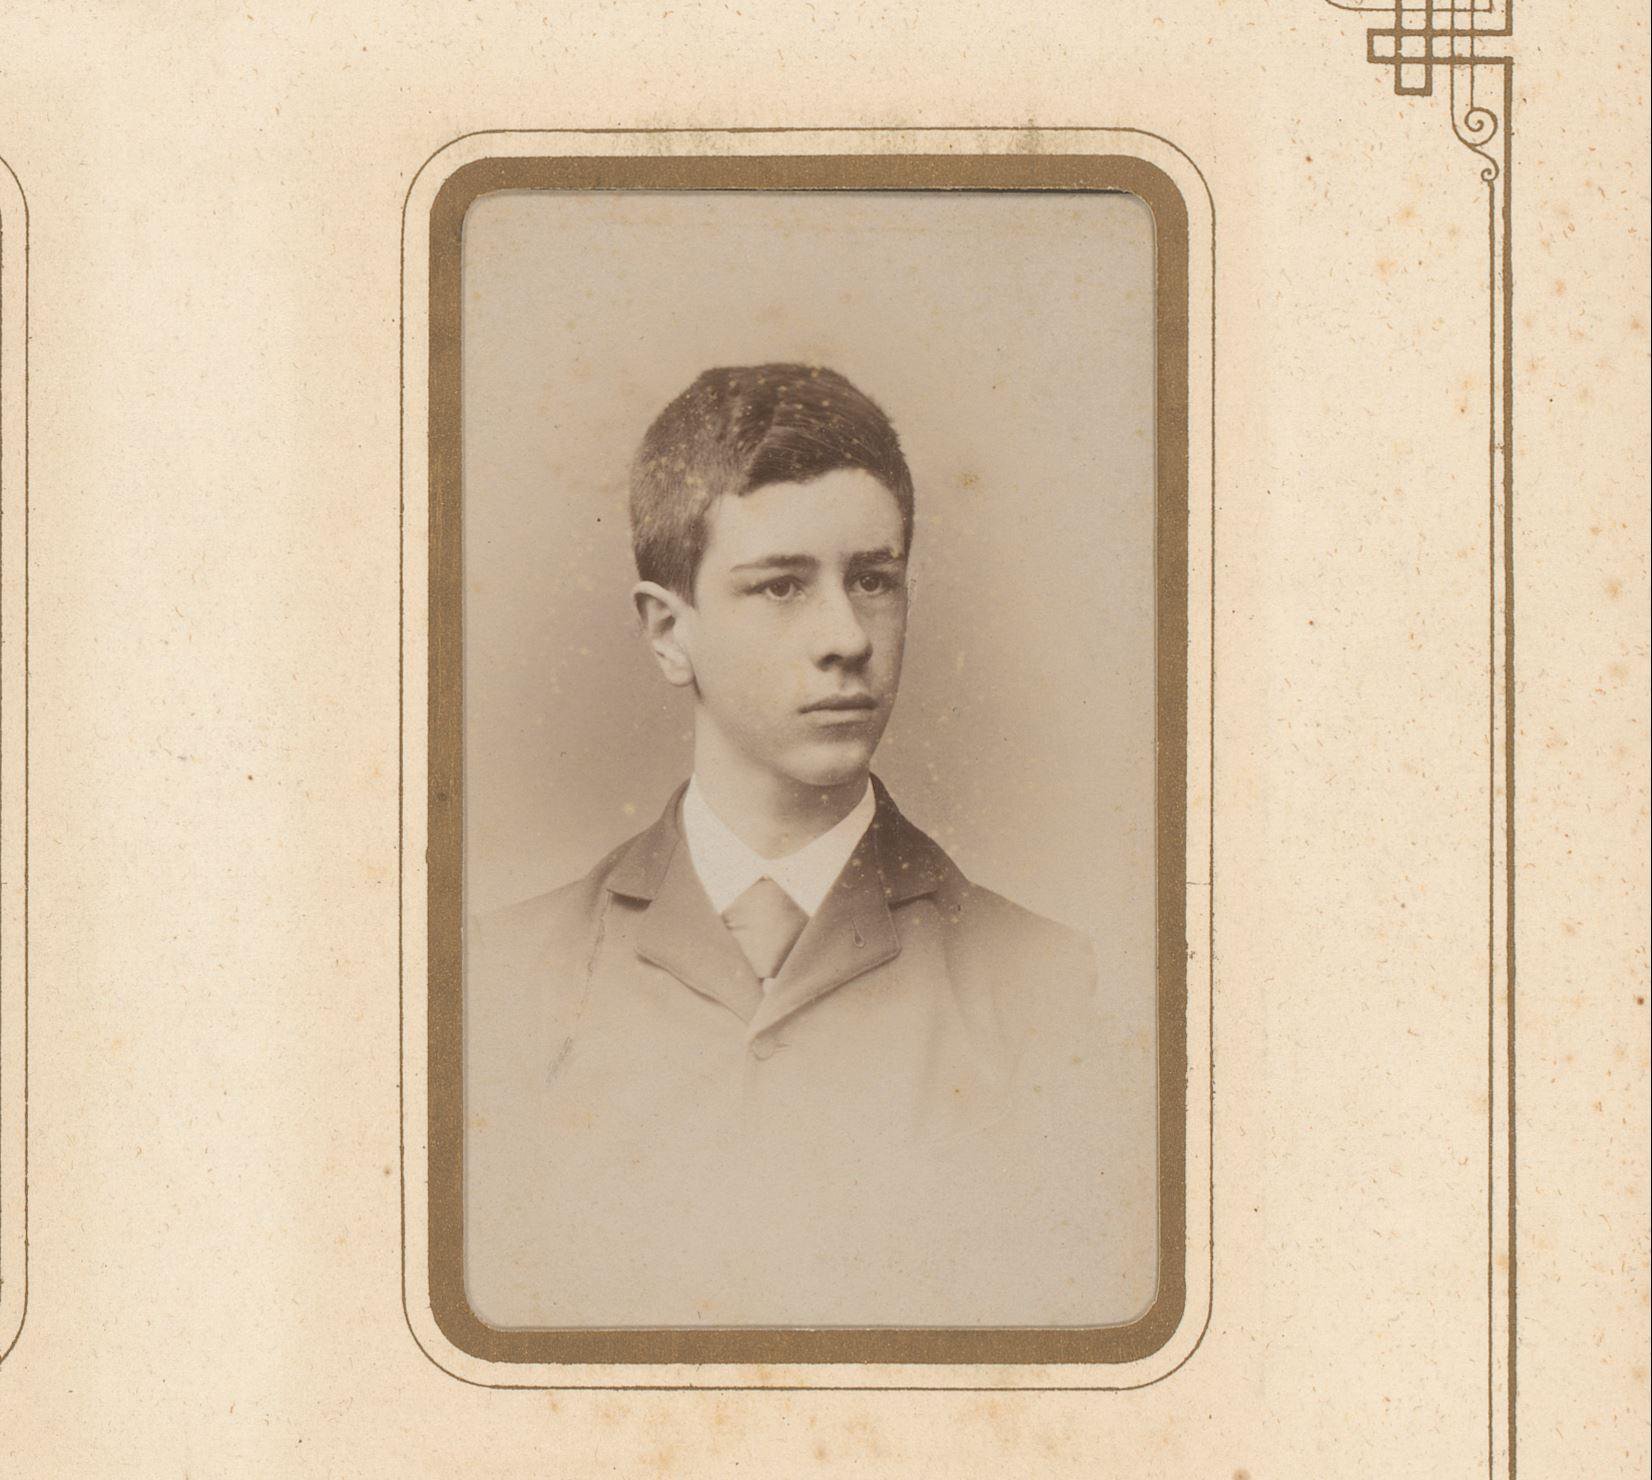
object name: photograph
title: Portret van een jongeman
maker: carl emil mögle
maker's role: fotograaf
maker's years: 1857-1934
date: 1886-1899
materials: cardboard, photographic support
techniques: albumen print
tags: historical persons, youth, adolescent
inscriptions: inscription: ‘C.E. Mögle/ fotograaf/ Rotterdam/ Moriaanstraat 5/ (...)’